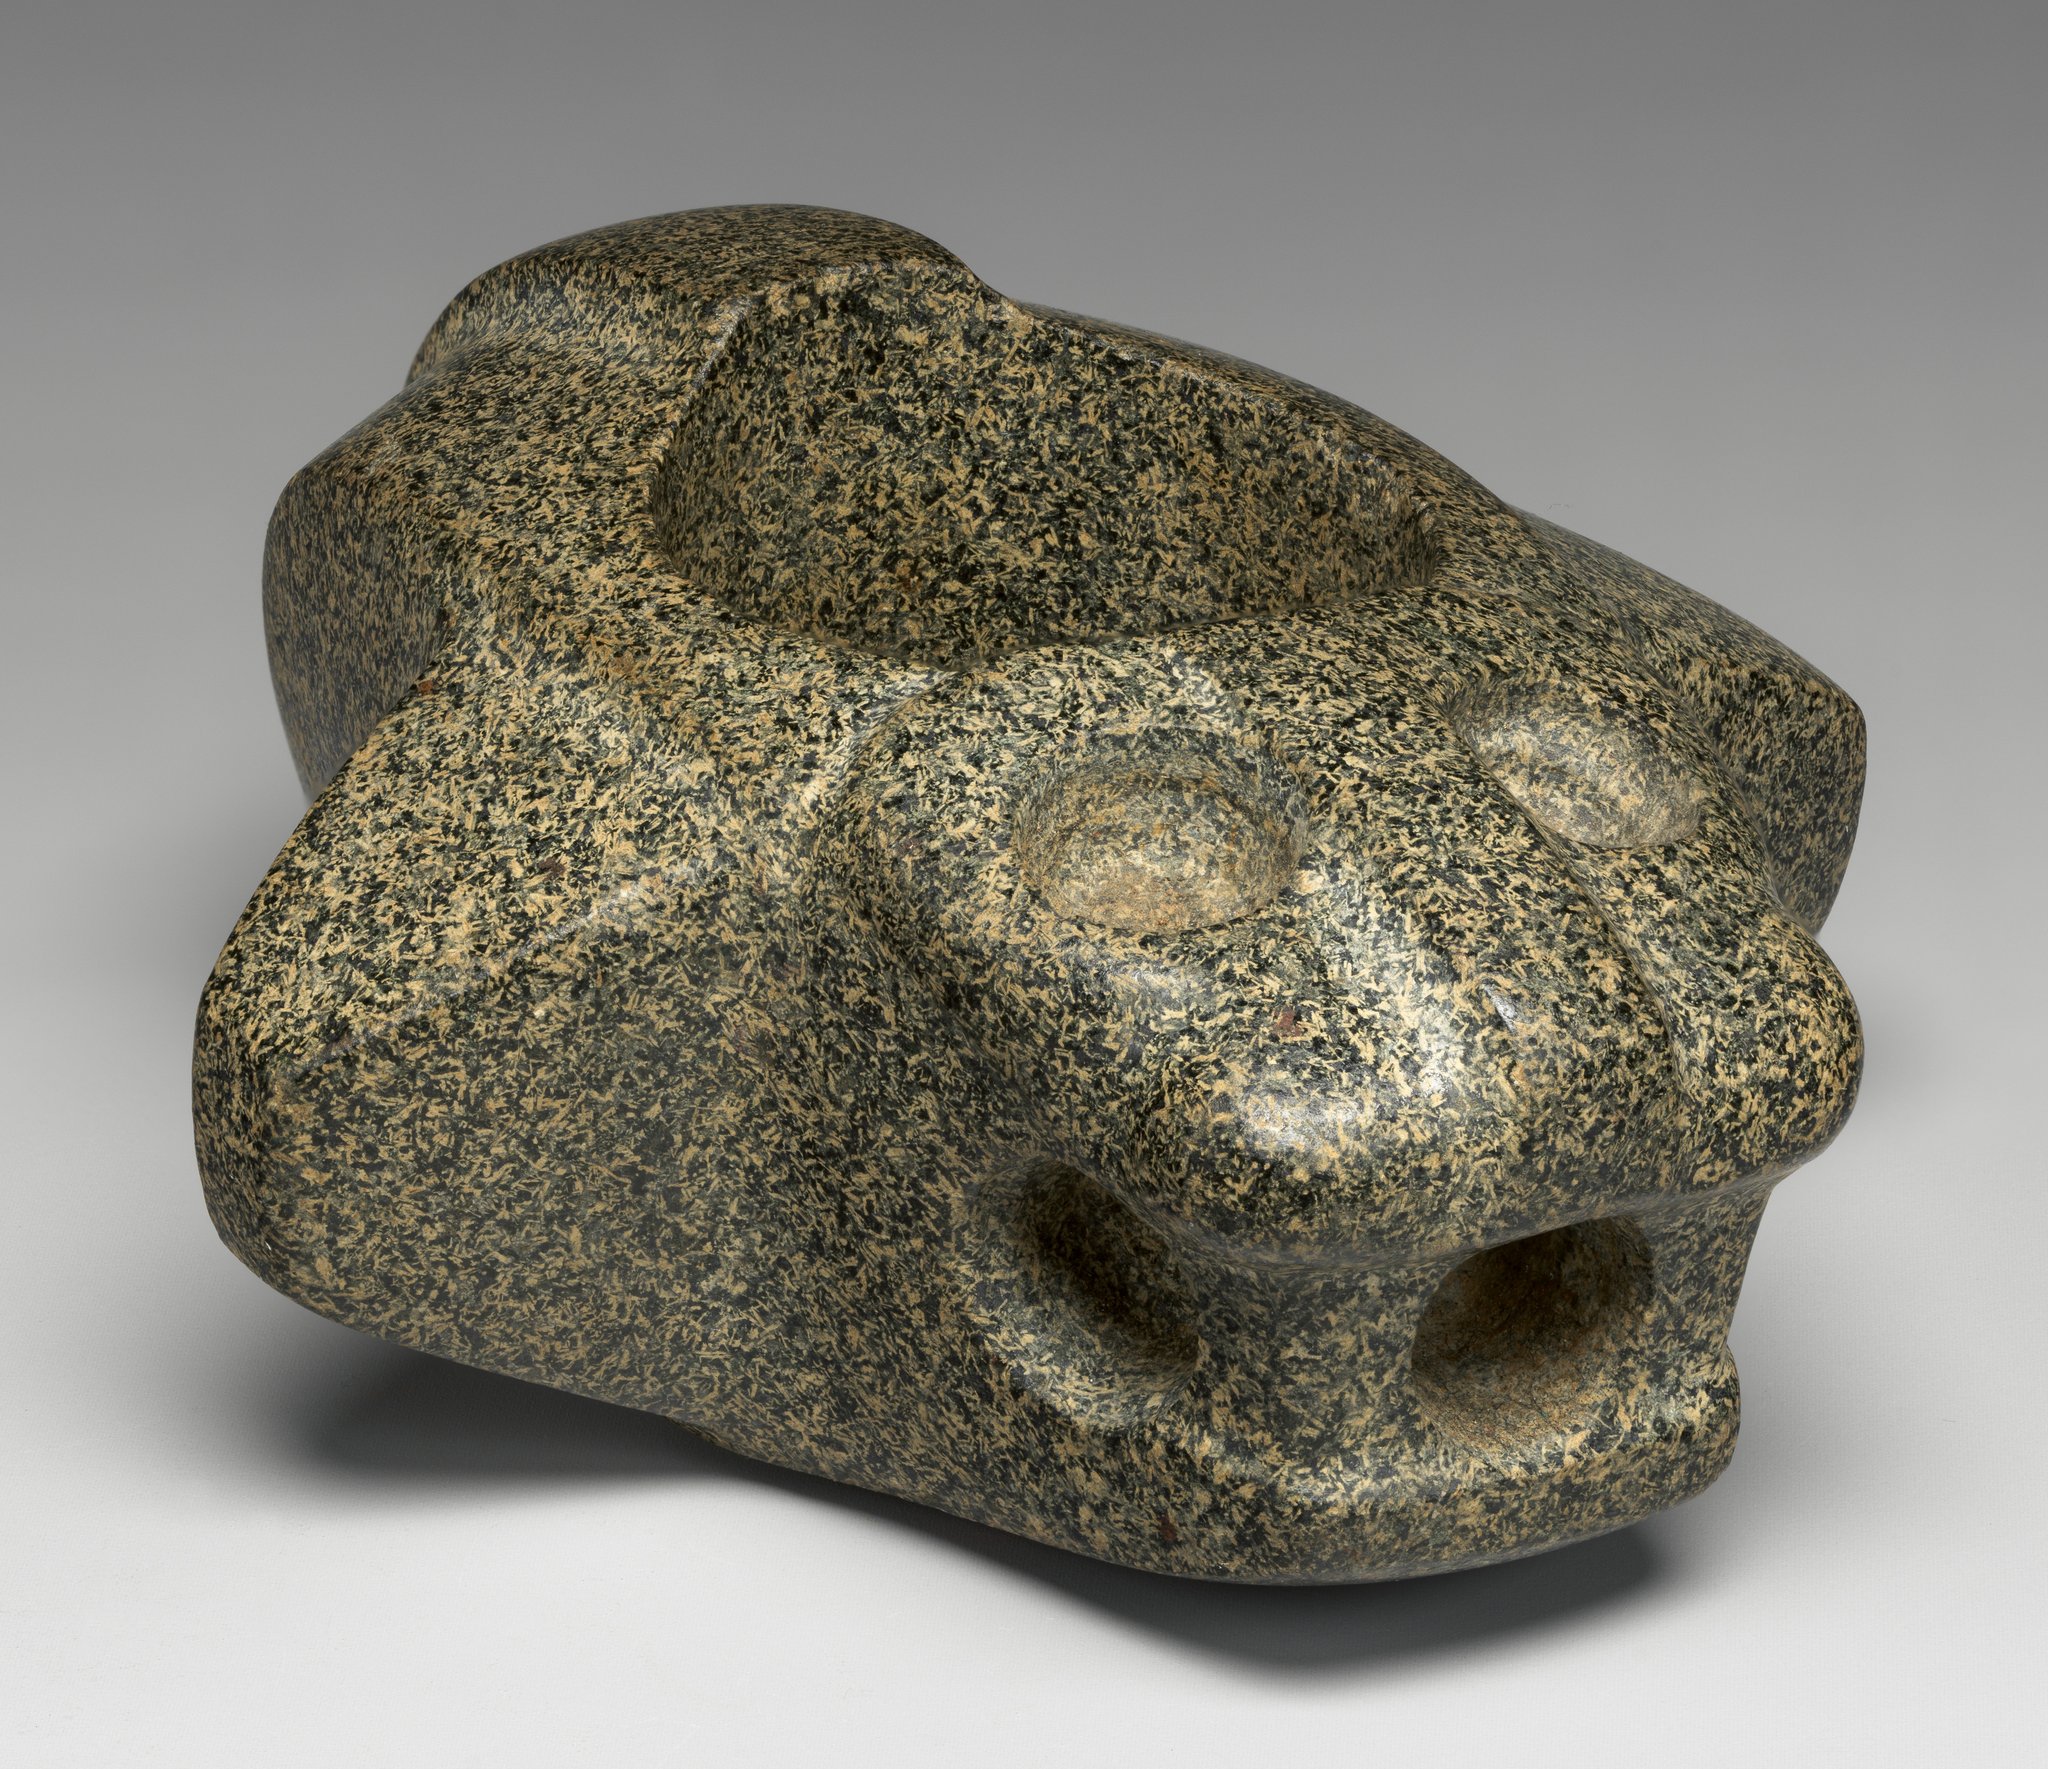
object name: mace head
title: Stone Animal Mace Head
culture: guanacaste-nicoya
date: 1-500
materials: stone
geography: costa rica